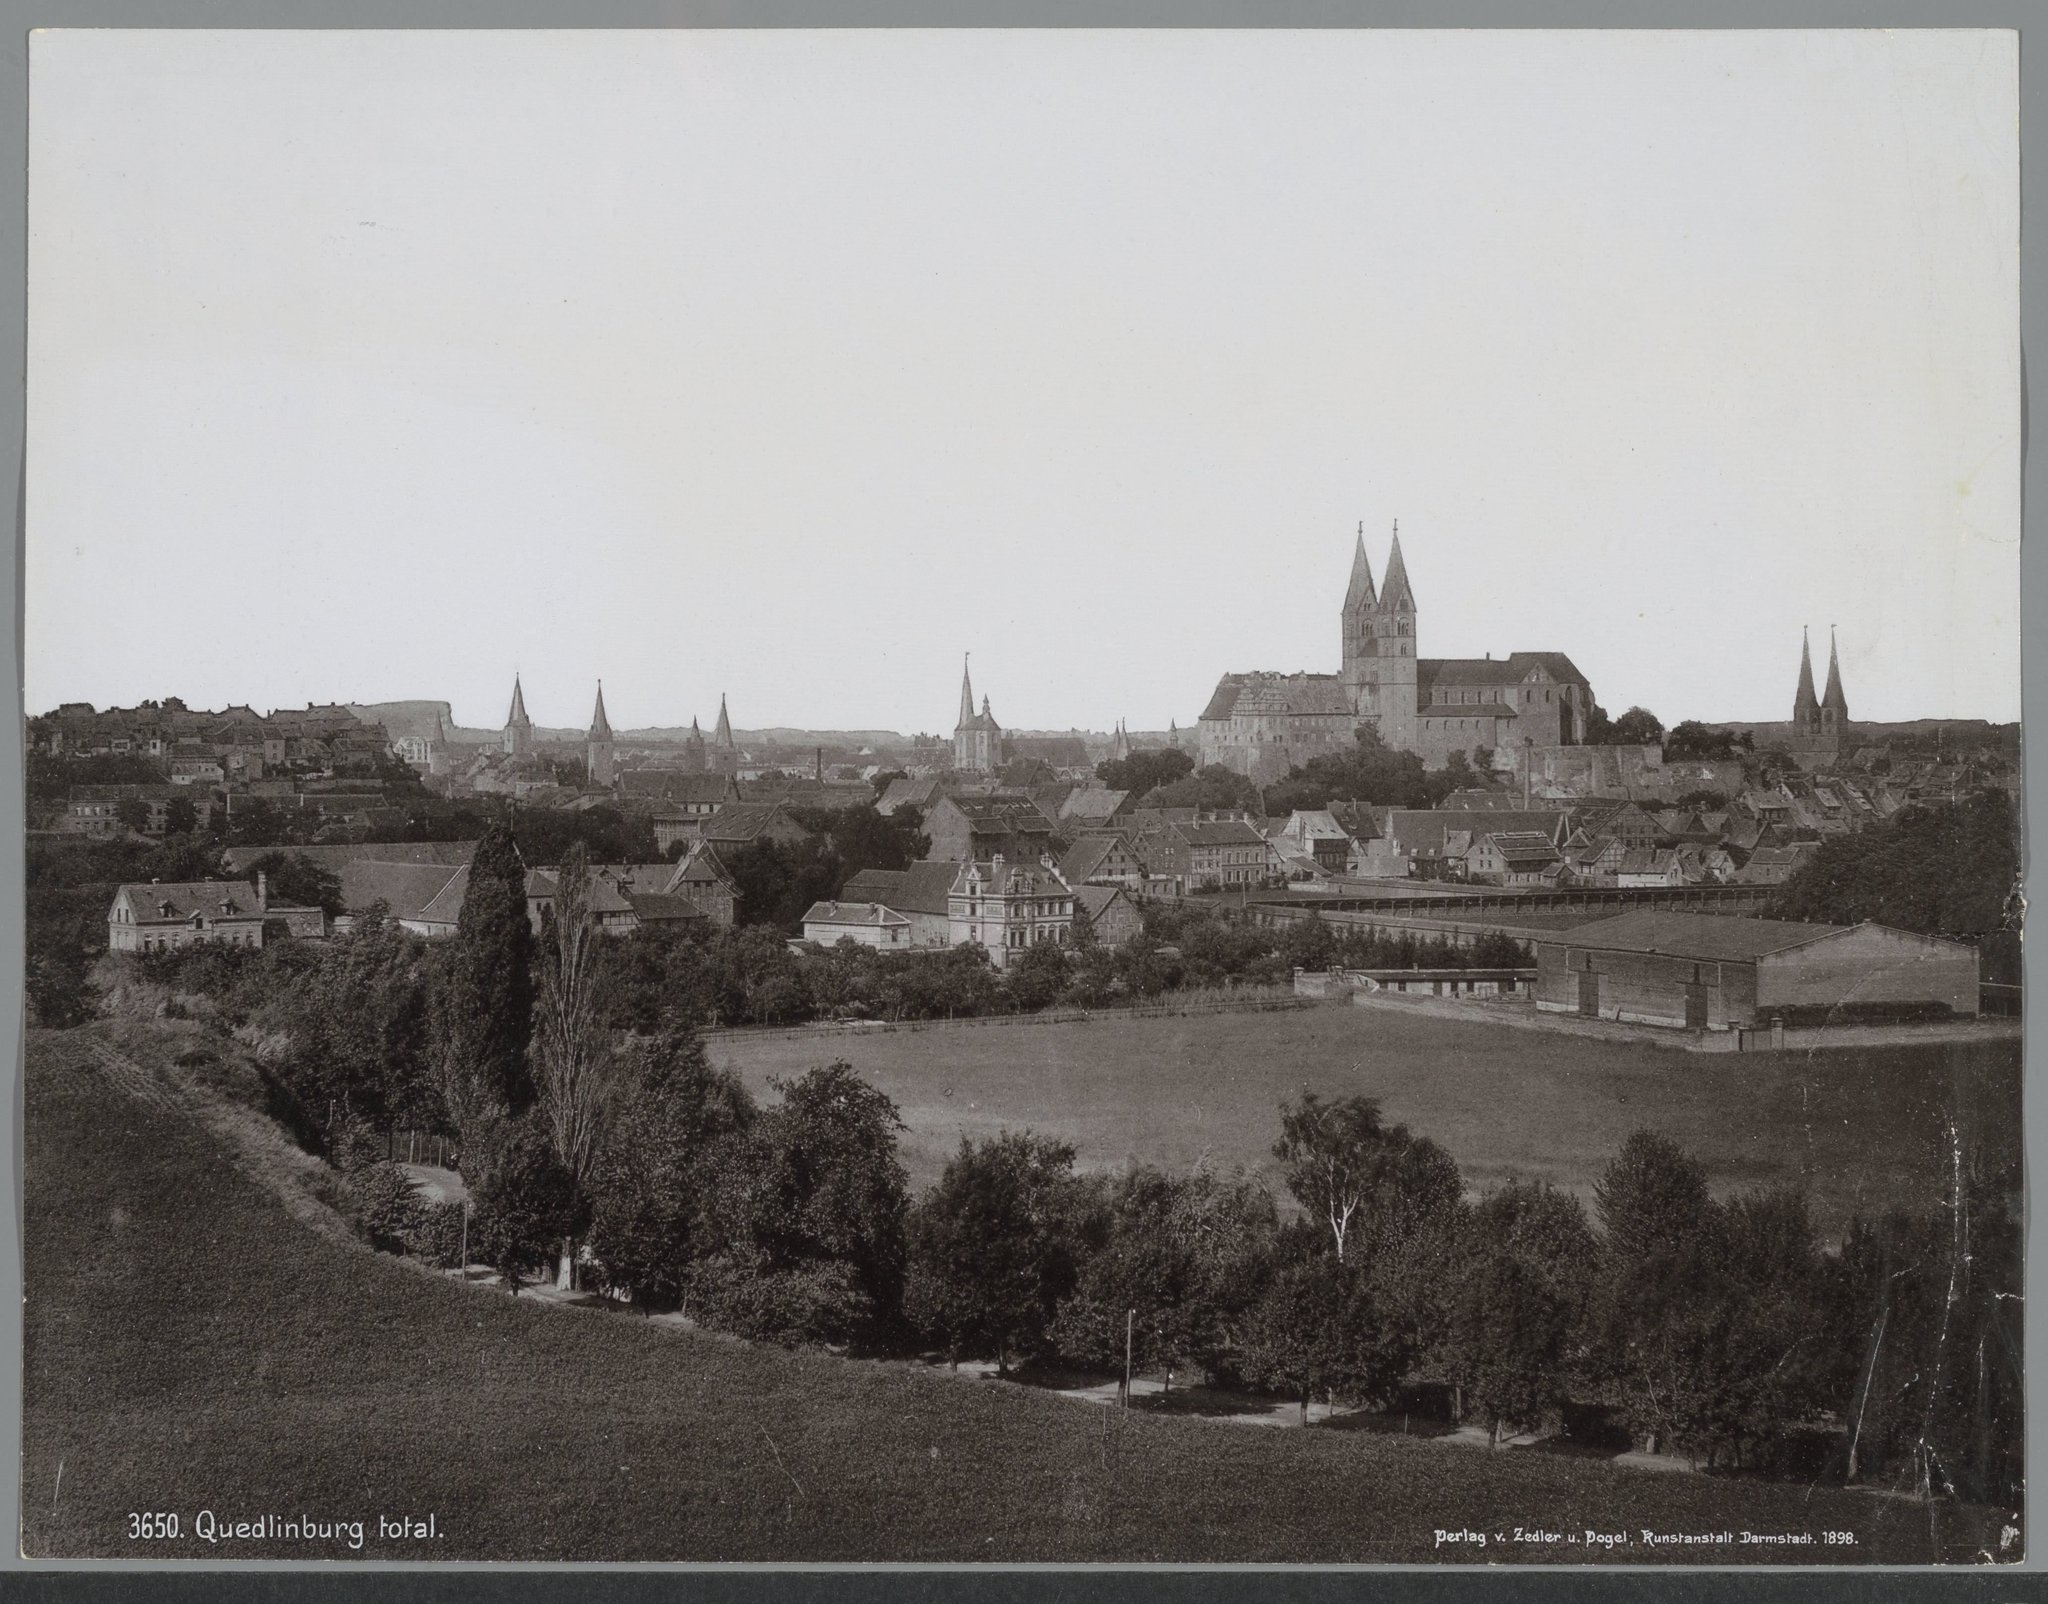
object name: photomechanical print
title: Quedlinburg Total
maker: Anonymous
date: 1898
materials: paper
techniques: photograph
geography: darmstadt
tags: city-view in general; 'veduta'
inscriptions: title: ‘3650. Quedlinburg Total’, date: ‘16 Aug. '12.’, inscription: ‘Verlag v. Zedler u. Vogel, Kunstanstalt Darmstadt. 1898.’